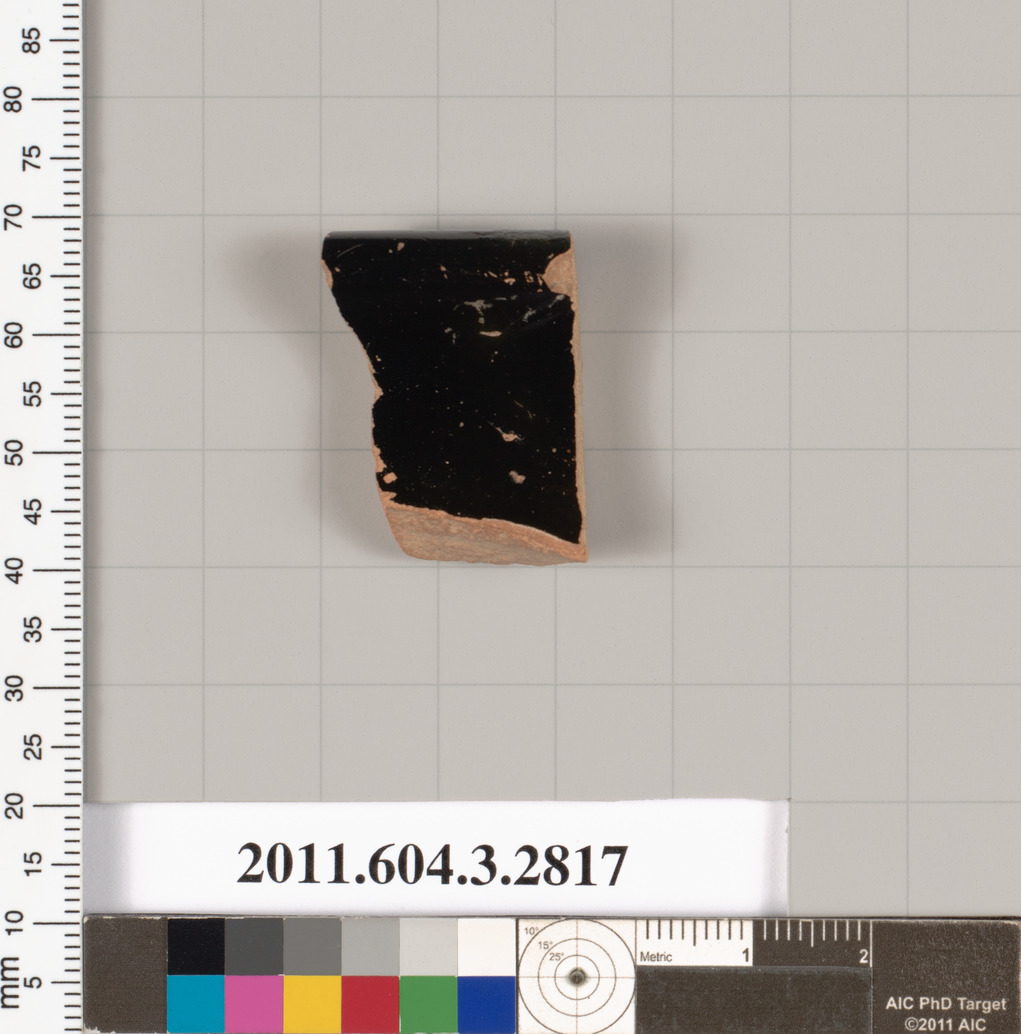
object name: kylix fragment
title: Terracotta rim fragment of a stemless kylix (drinking cup)?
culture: greek, attic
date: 500-401 BCE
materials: terracotta